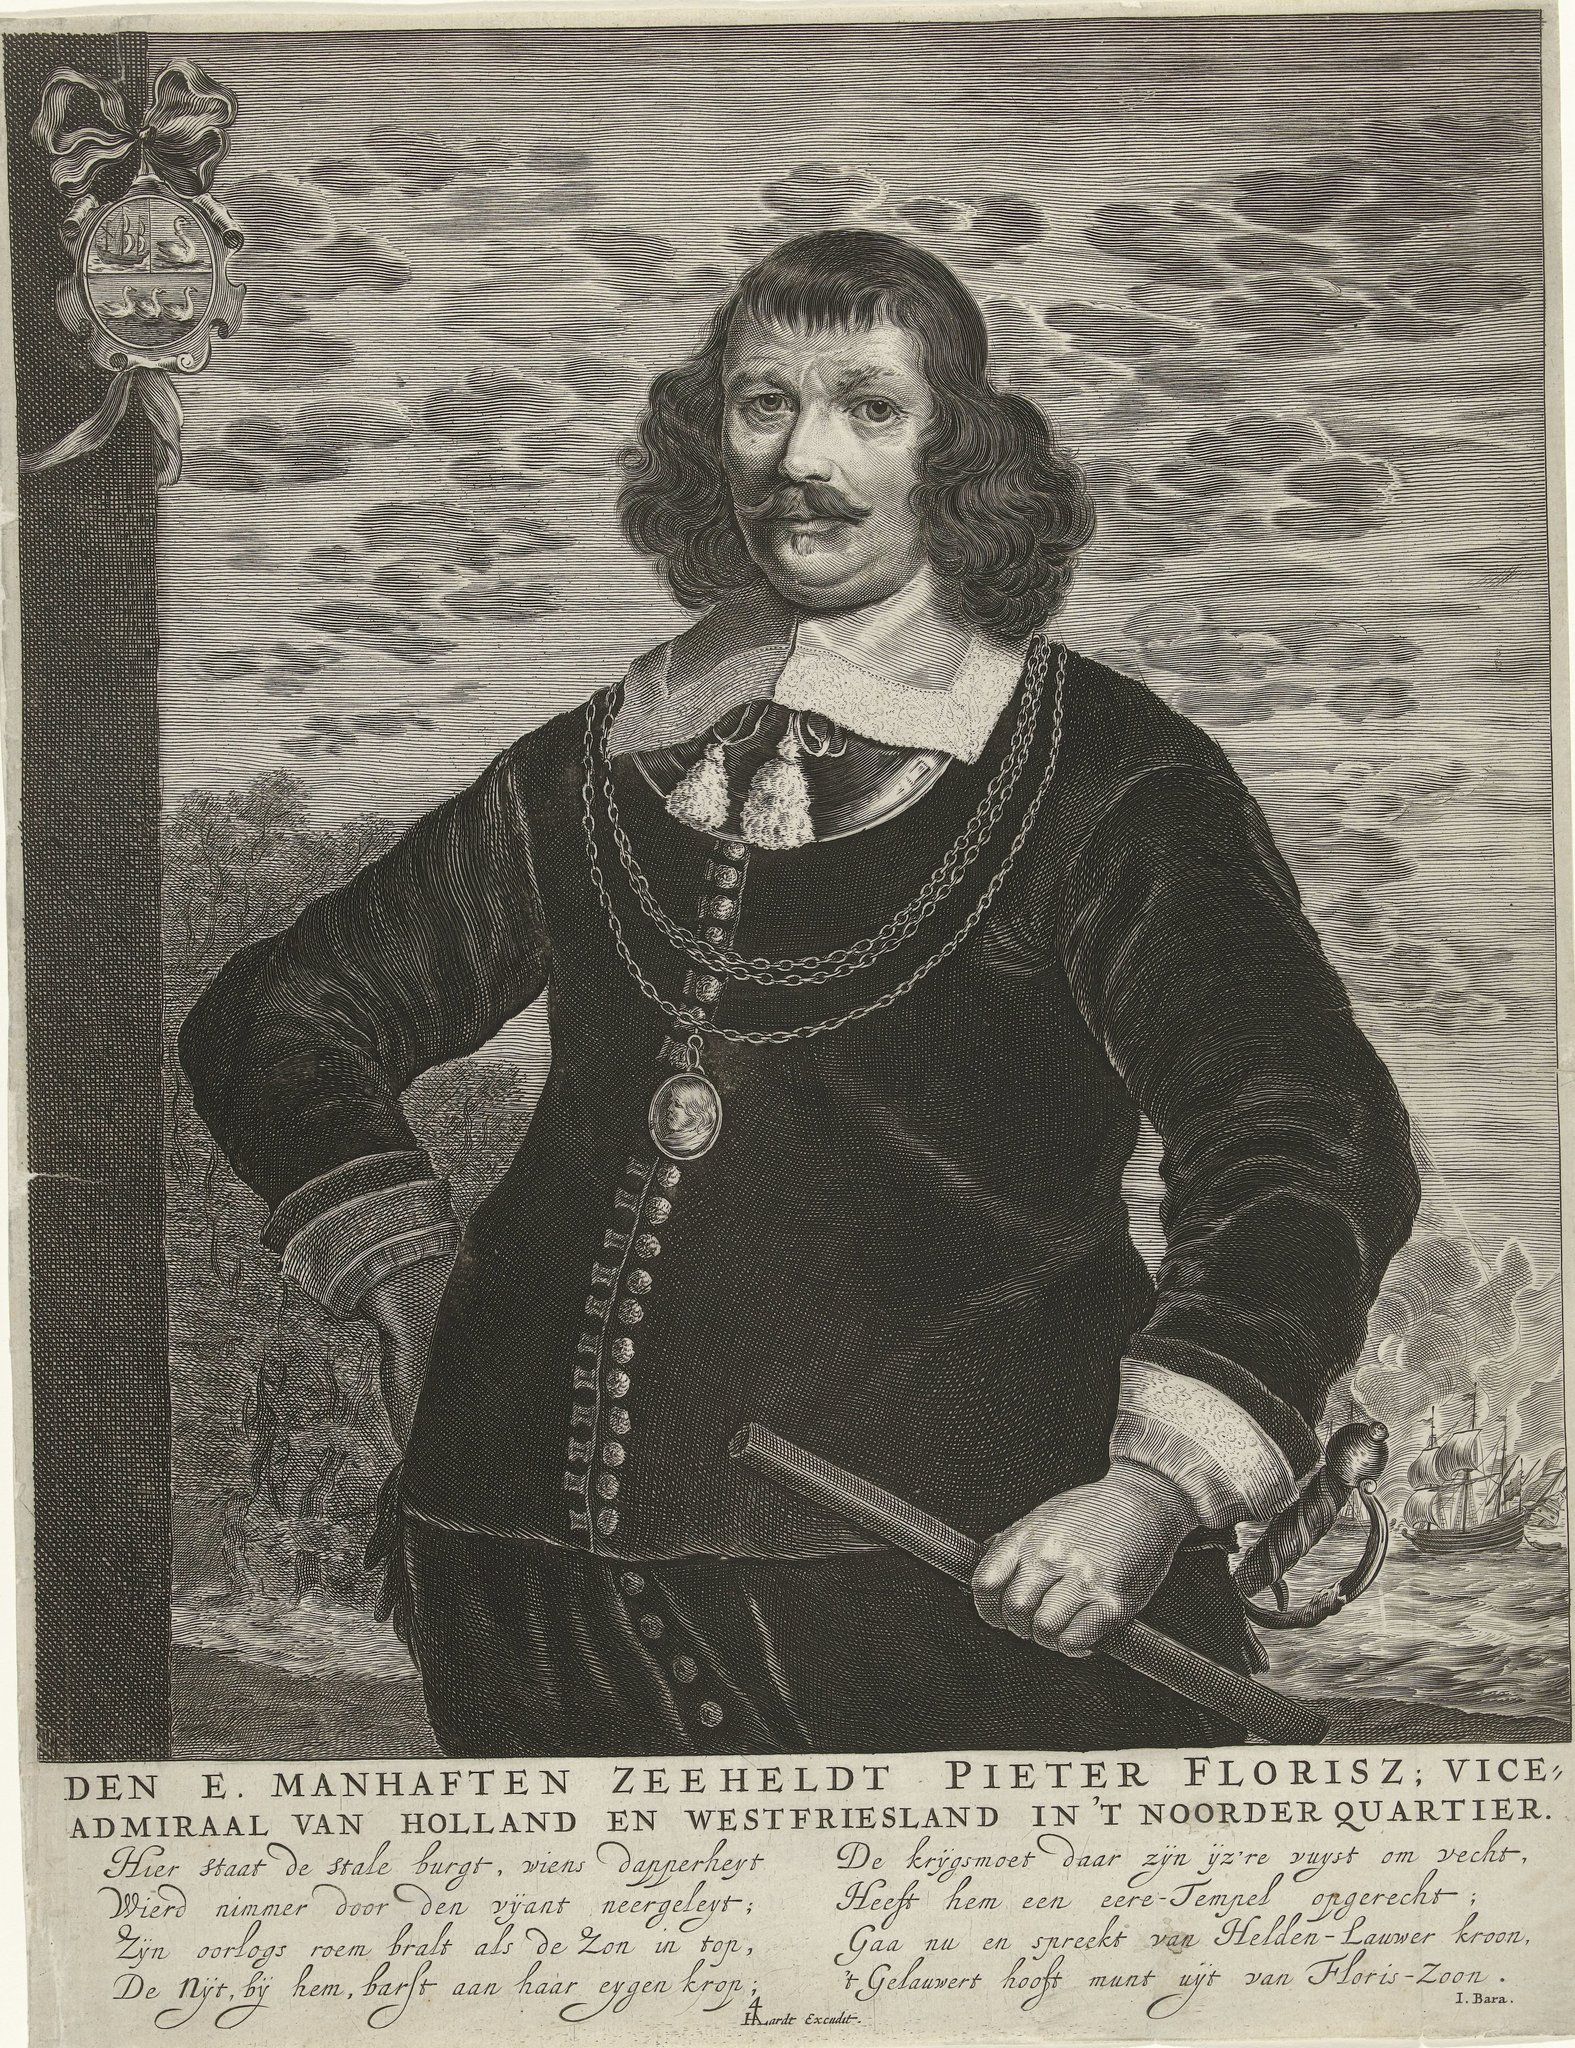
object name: print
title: Portret van Pieter Florisse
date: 1658-1684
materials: paper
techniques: engraving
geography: northern netherlands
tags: sont, vice-admiraal, pieter florisse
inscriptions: collector's mark: Lugt 2228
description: Kniestuk naar links van Pieter Florisz. met in zijn hand een commandostaf. Links een zuil waarop bovenaan zijn wapen, op de achtergrond een zee met schepen. Onder het portret zijn naam en titel in twee regels in het Nederlands. Daaronder in twee kolommen van elk vier regels een gedicht in het Nederlands.